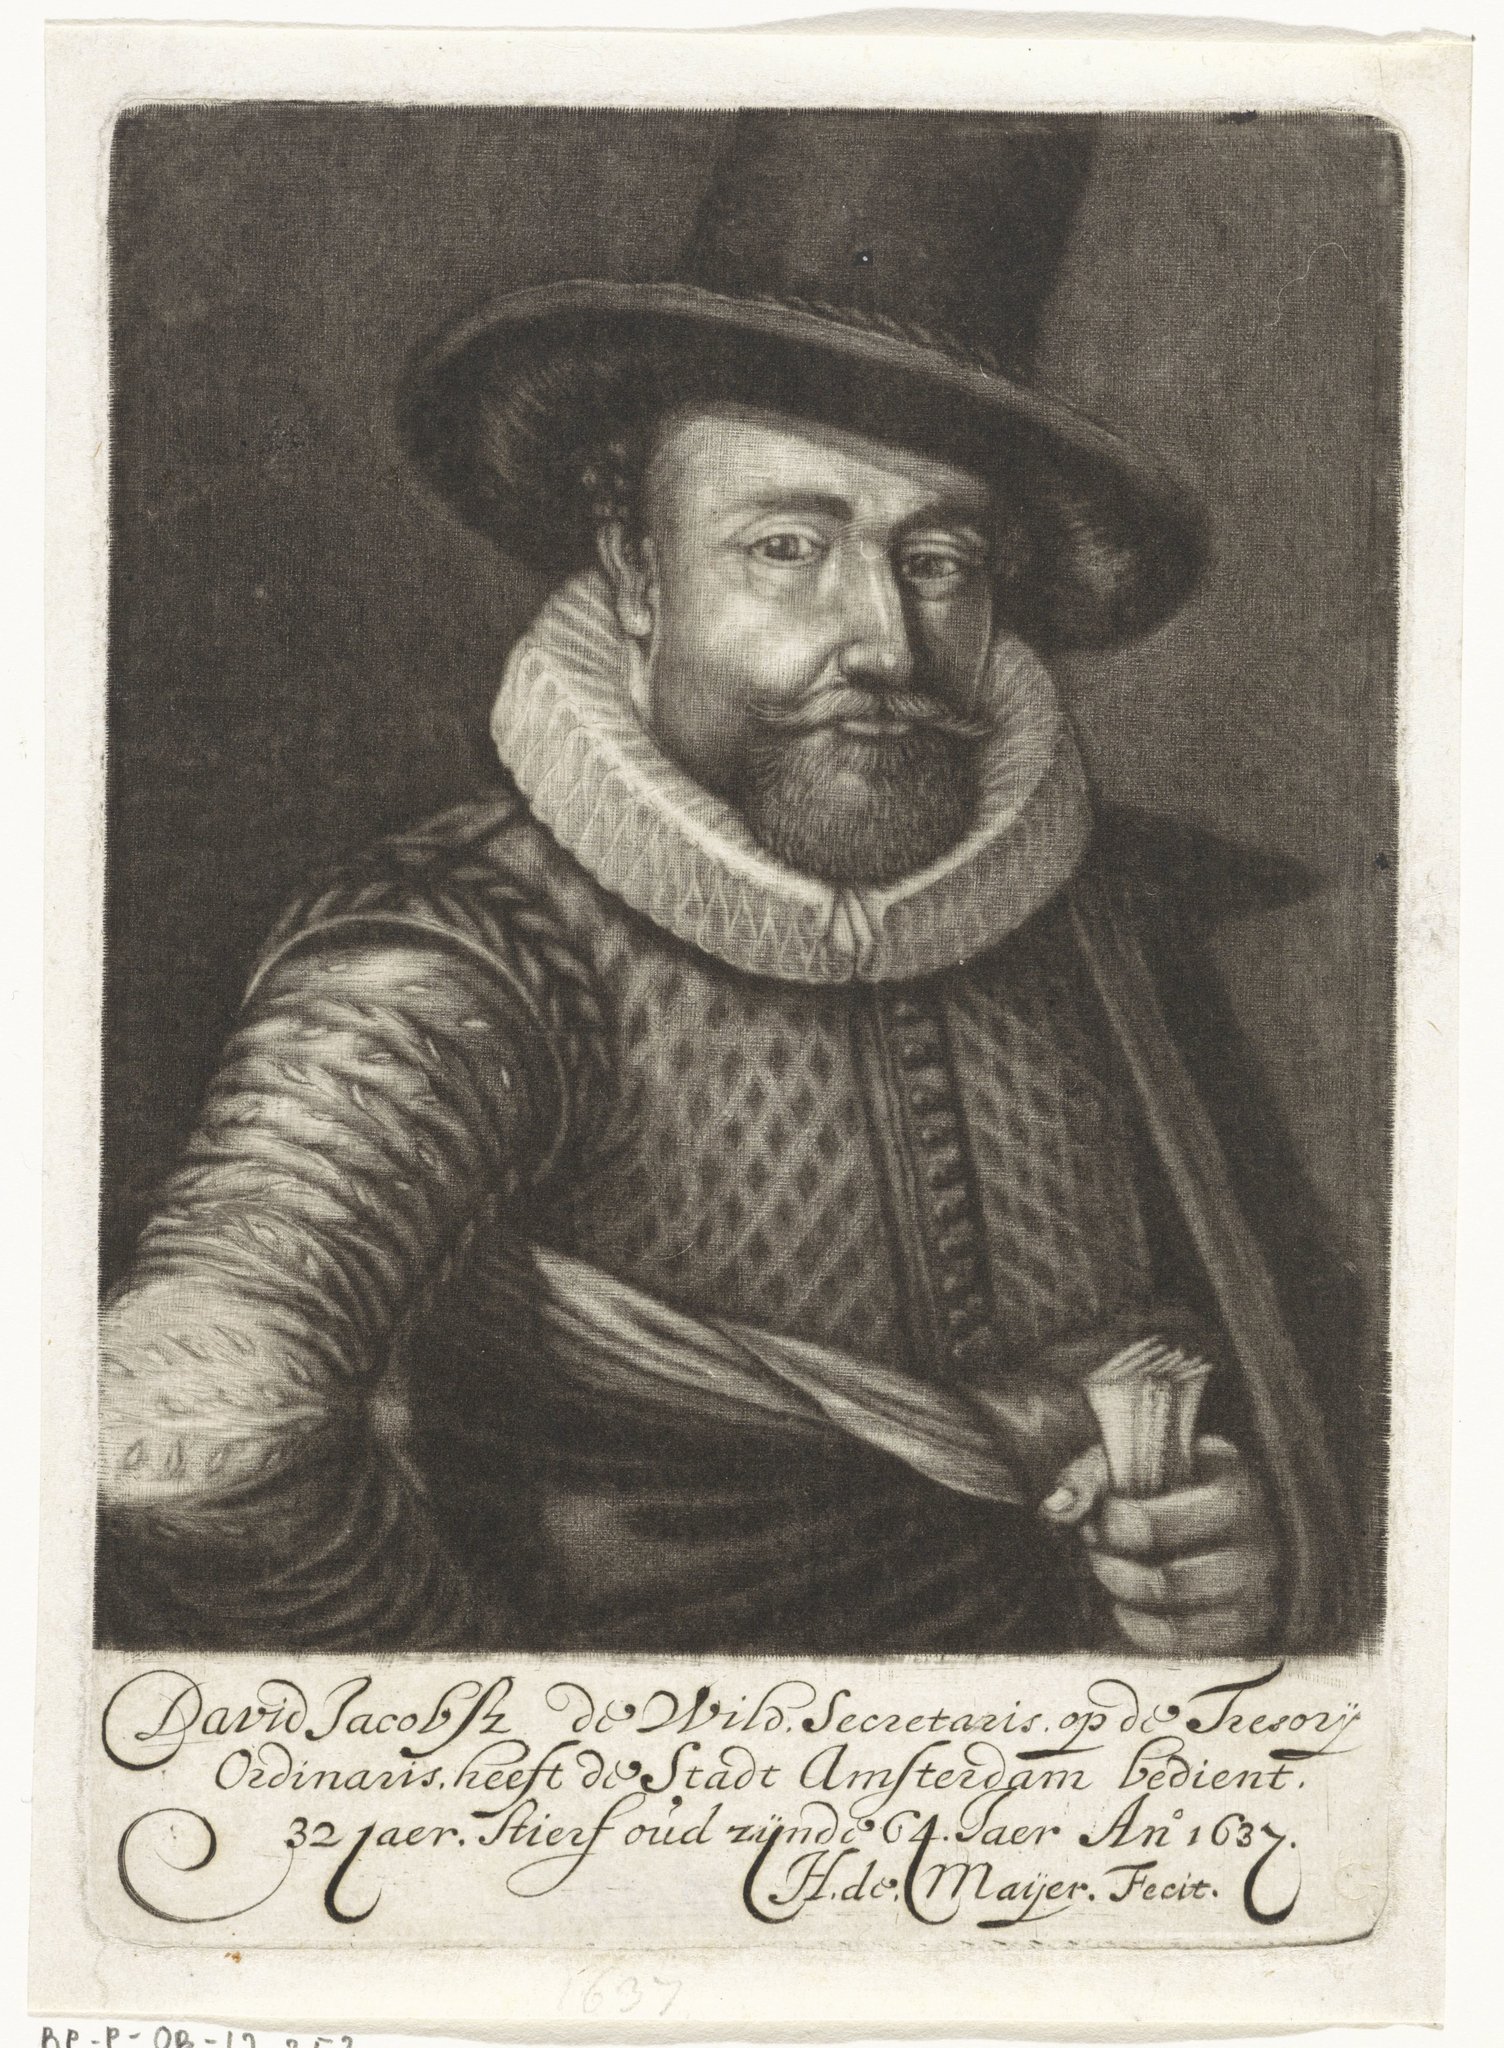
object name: print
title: Portret van David Jacobsz. de Wildt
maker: harmen de mayer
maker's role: print maker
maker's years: 1624-1701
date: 1651-1701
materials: paper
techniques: engraving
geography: amsterdam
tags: head-gear: hat (+ men's clothes)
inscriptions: collector's mark: Lugt 1119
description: De thesaurier David Jacobsz. de Wildt op 32-jarige leeftijd. Hij draagt een hoed en heeft in de hand een stapel biljetten.